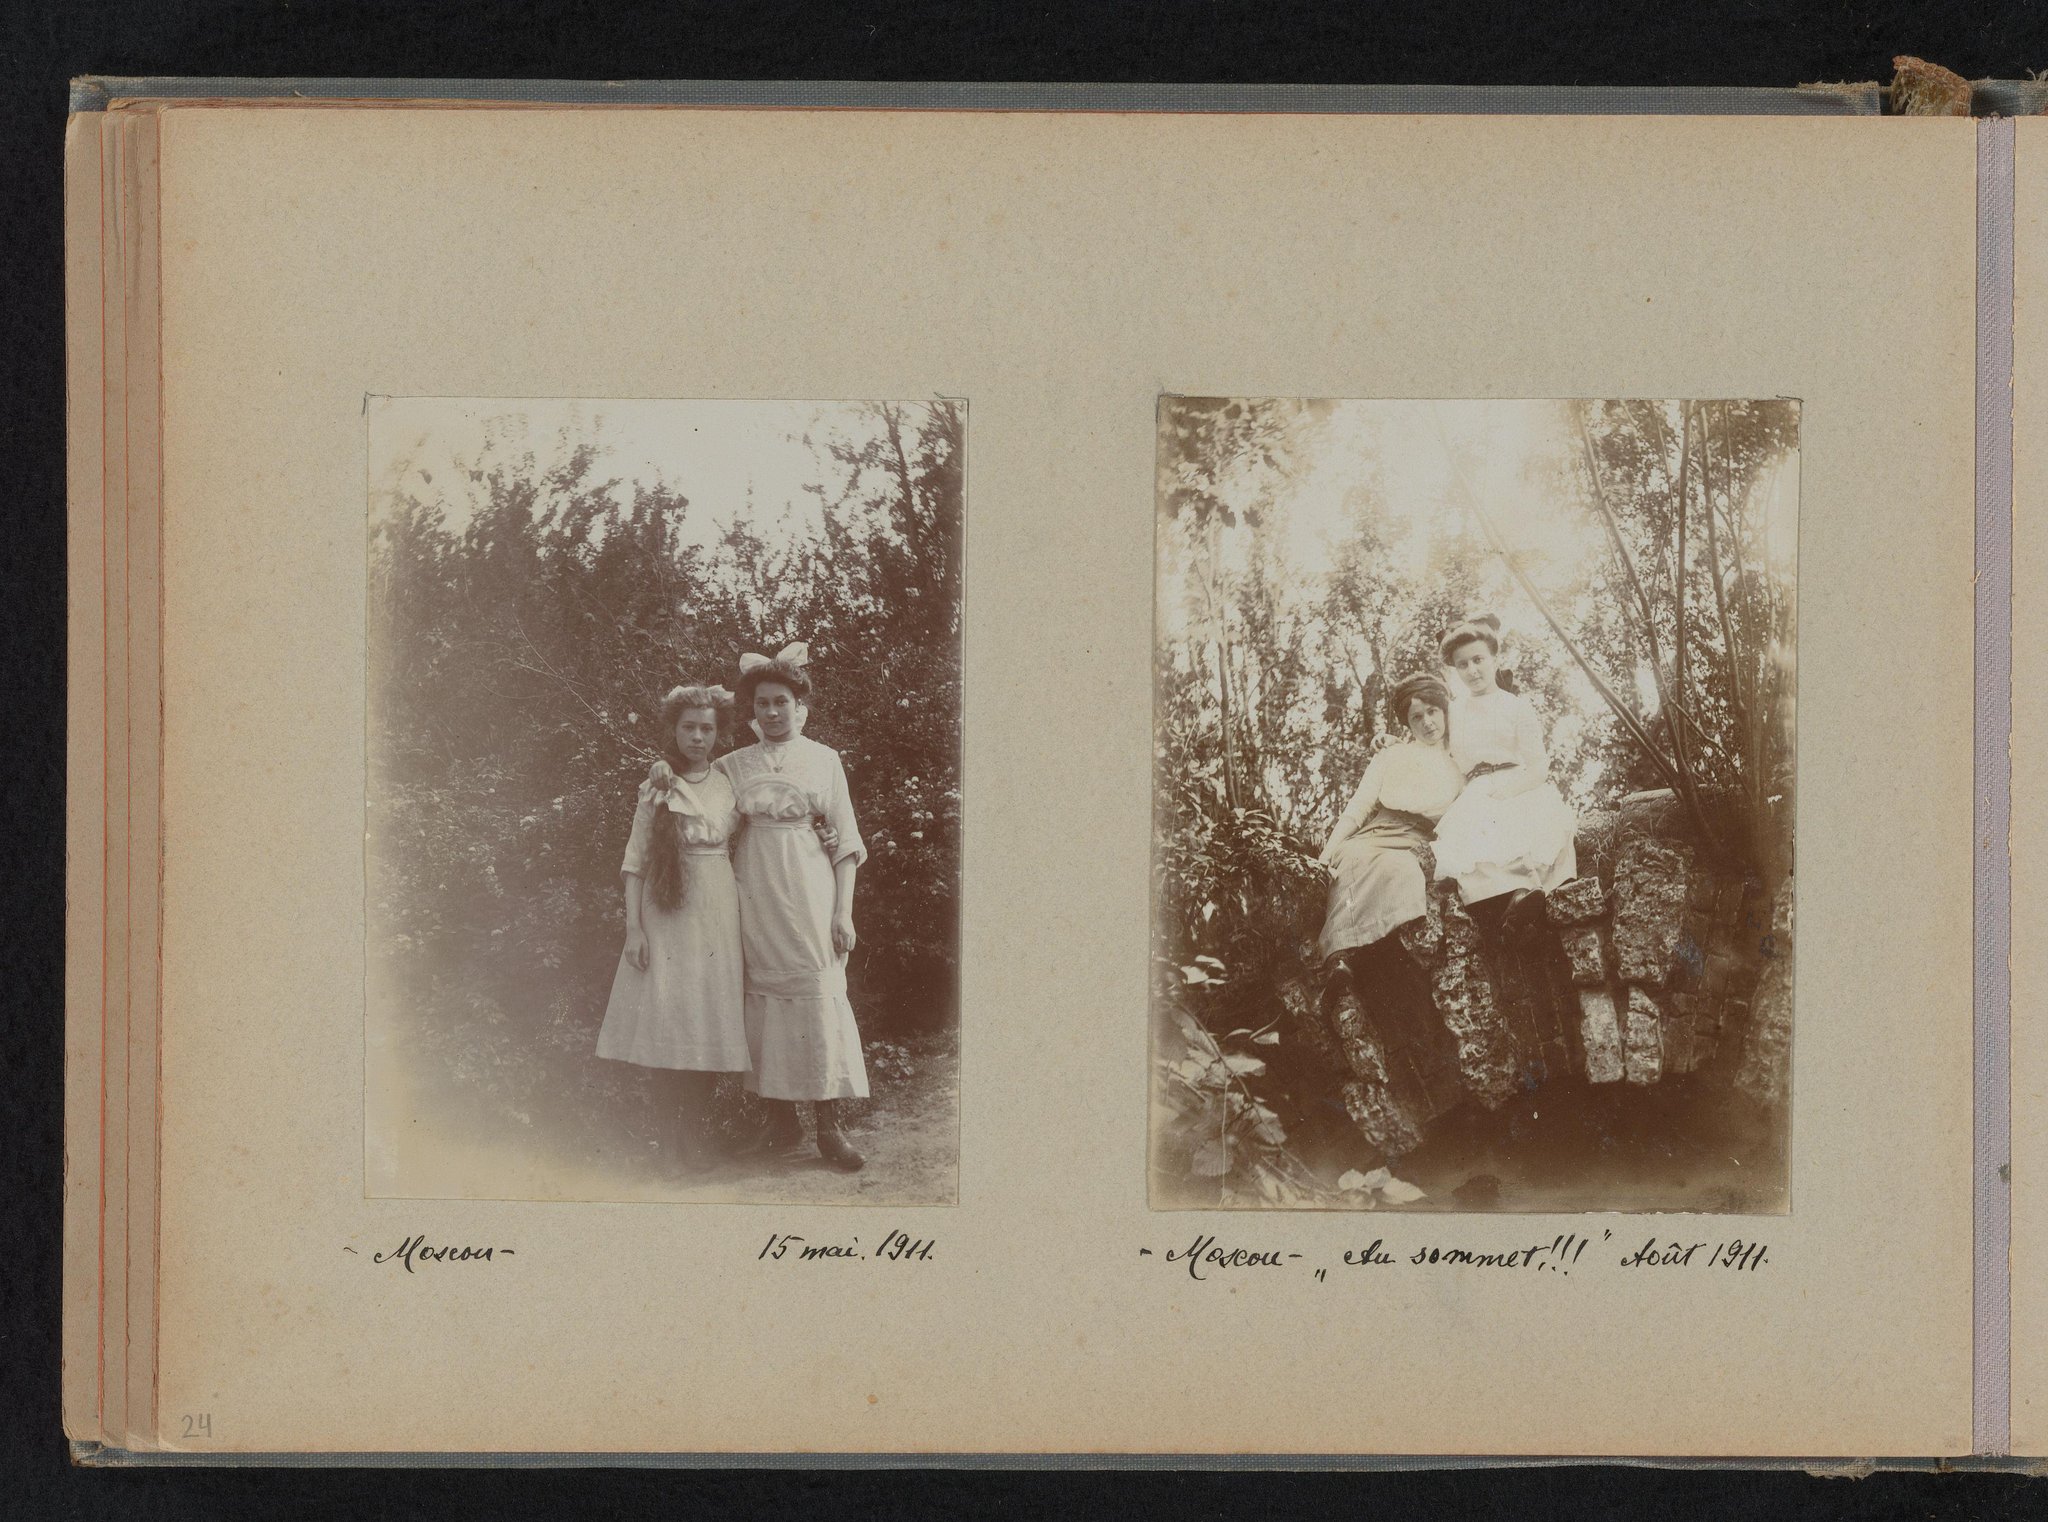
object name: album leaf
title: Portret van twee jonge vrouwen voor struiken en portret van twee jonge vrouwen zittend op een stenen boog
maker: Anonymous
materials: paper, cardboard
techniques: collodion silver print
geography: moscow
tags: historical persons - bb - woman, shrubs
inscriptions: inscription: ‘- Moscou - 15 mai. 1911.’, inscription: ‘- Moscou - "etu sommet!!!" Août 1911.’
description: Deze foto's maken deel uit van een album.